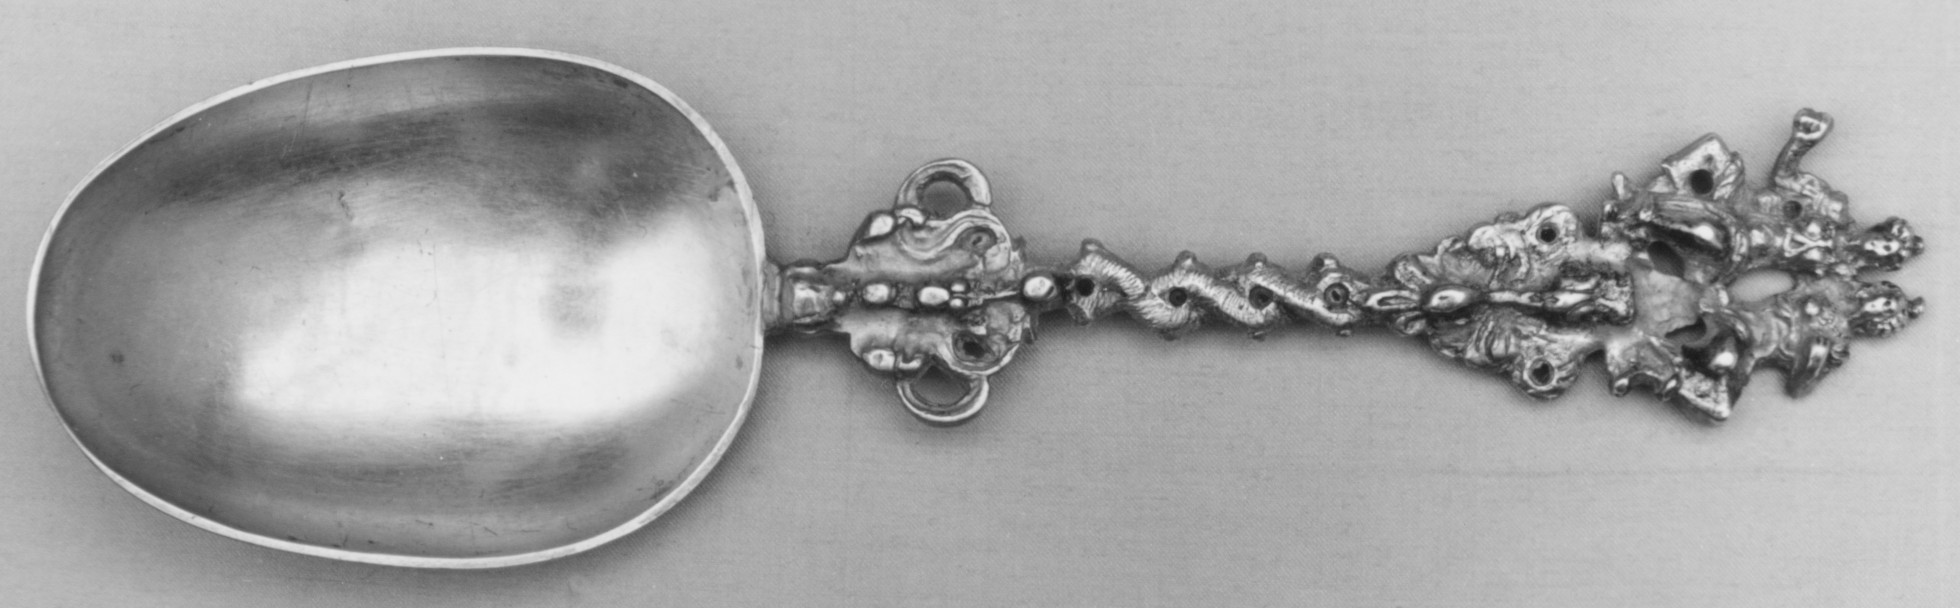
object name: spoon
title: Figure-top spoon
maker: ate scheverstein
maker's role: maker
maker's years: 1693-1773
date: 1751-1775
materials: silver